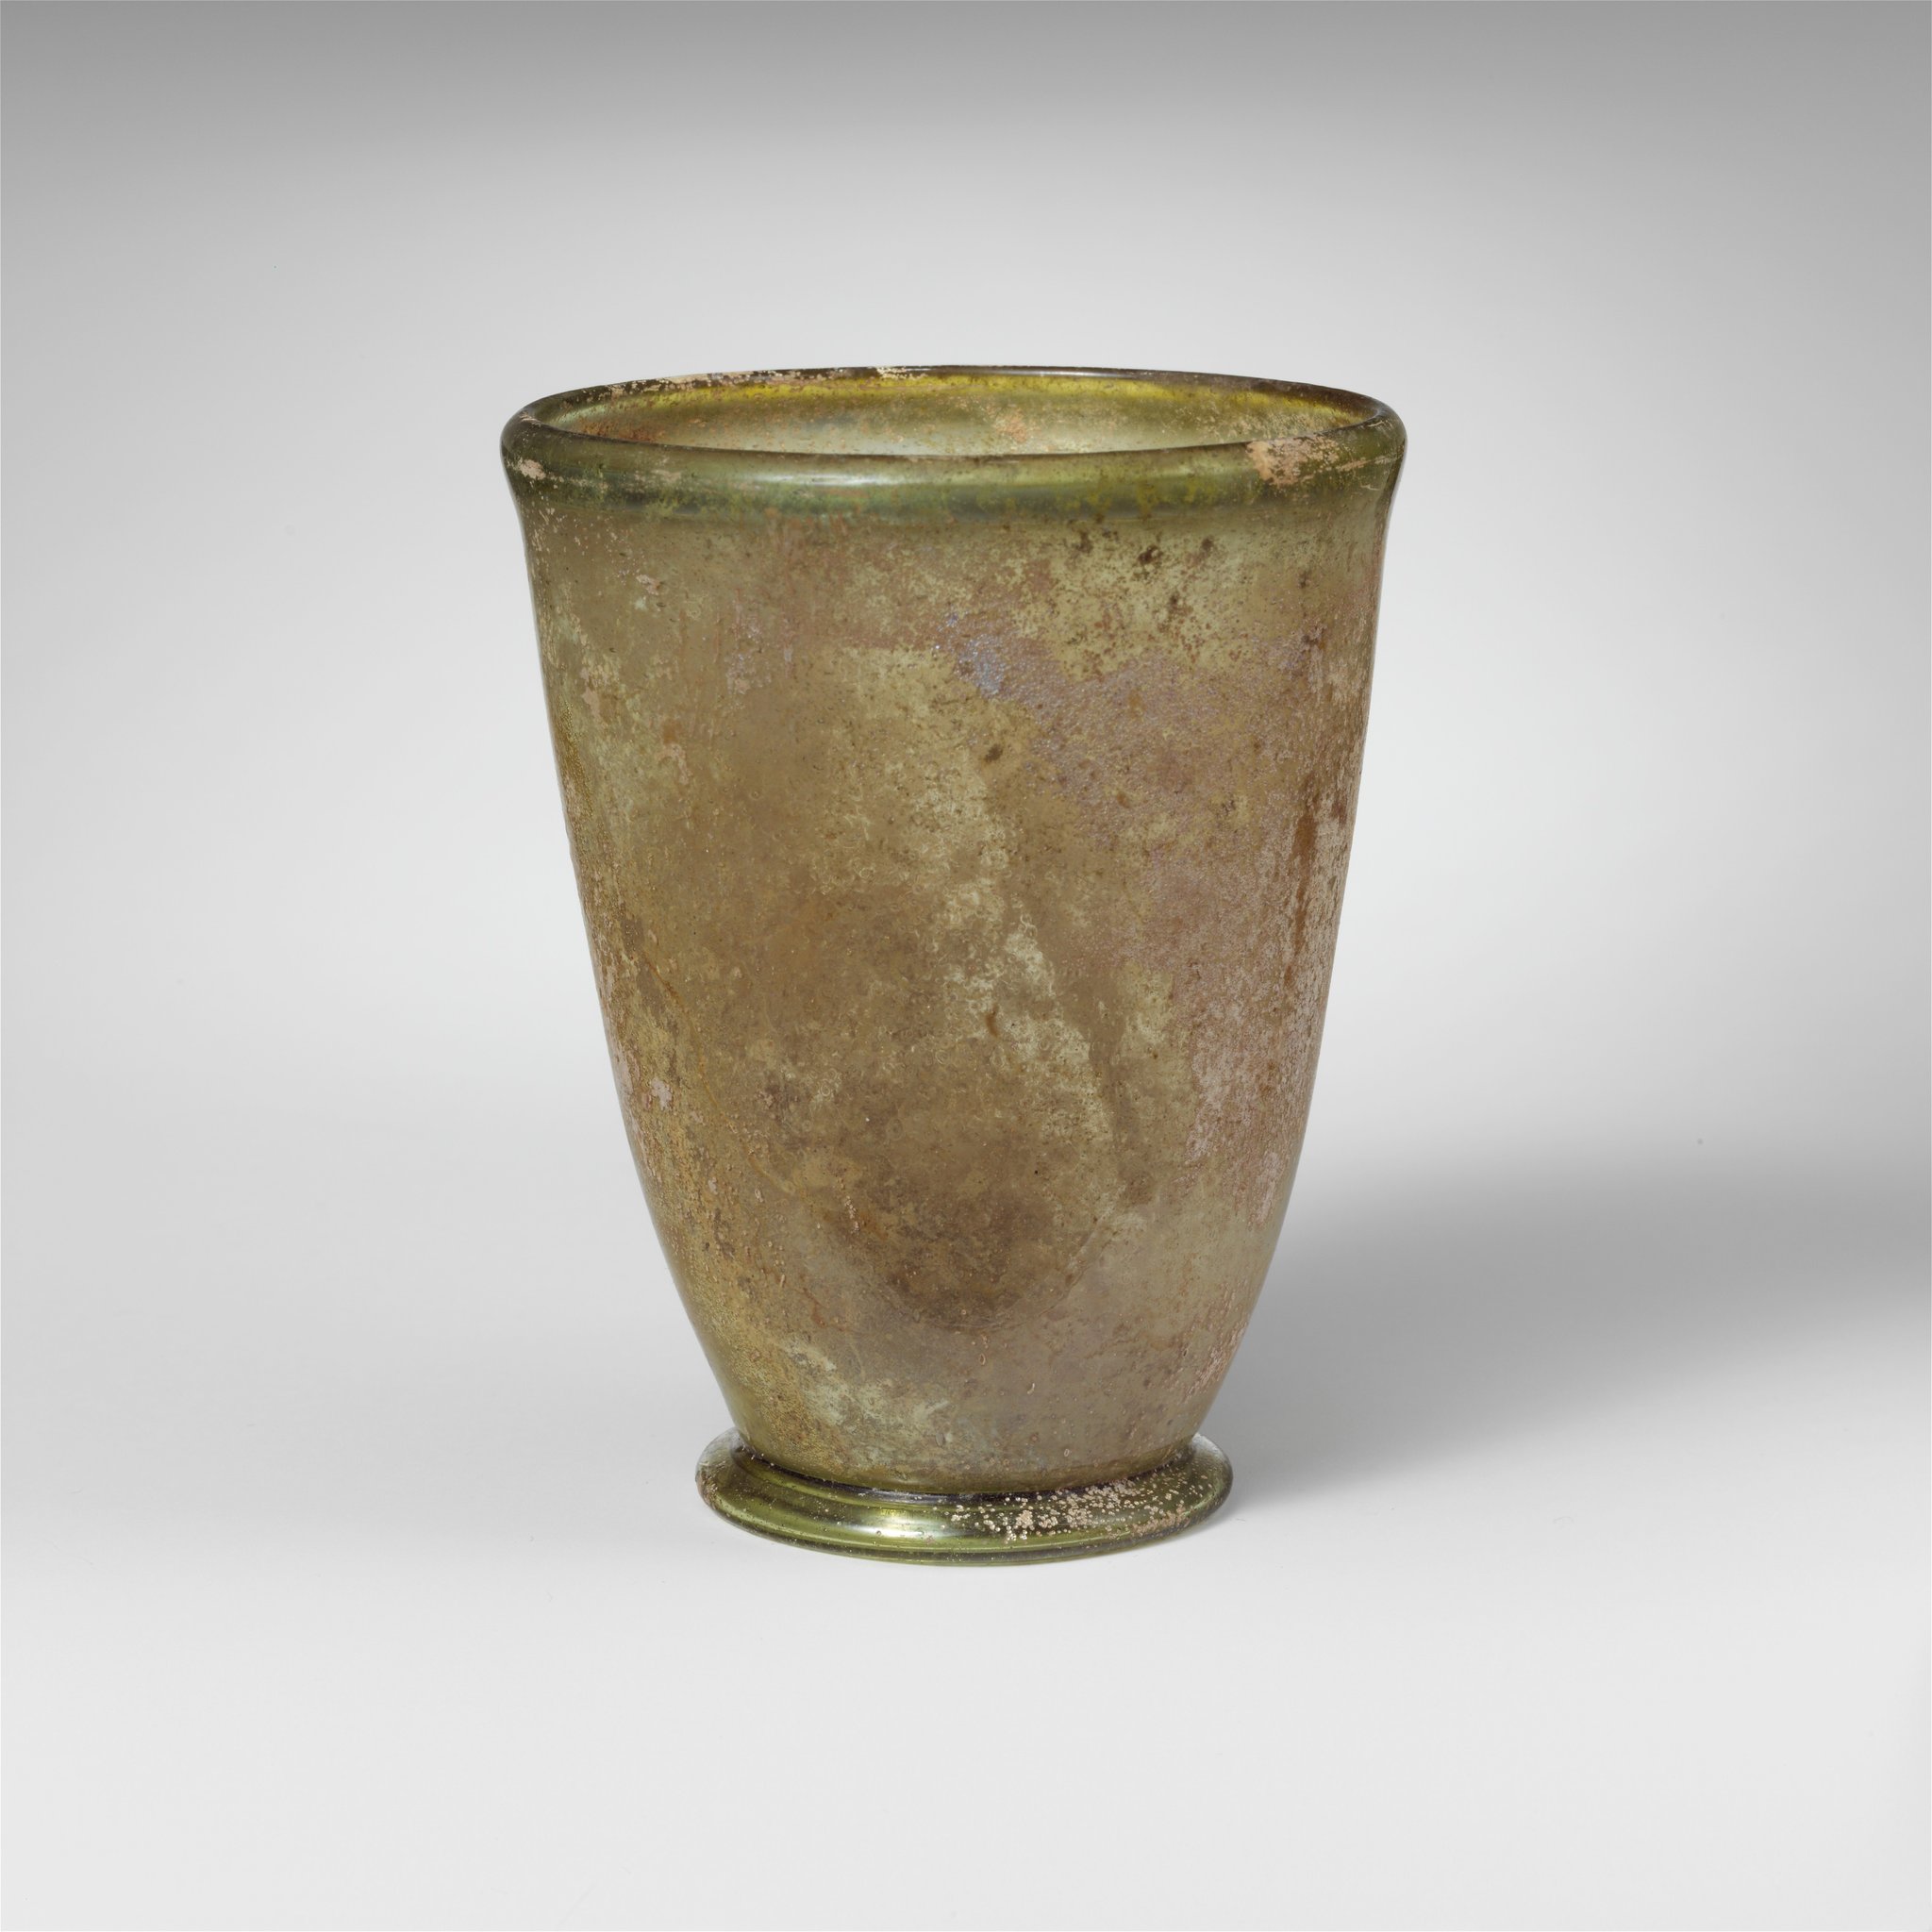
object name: beaker or cup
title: Glass beaker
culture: roman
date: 101-300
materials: glass